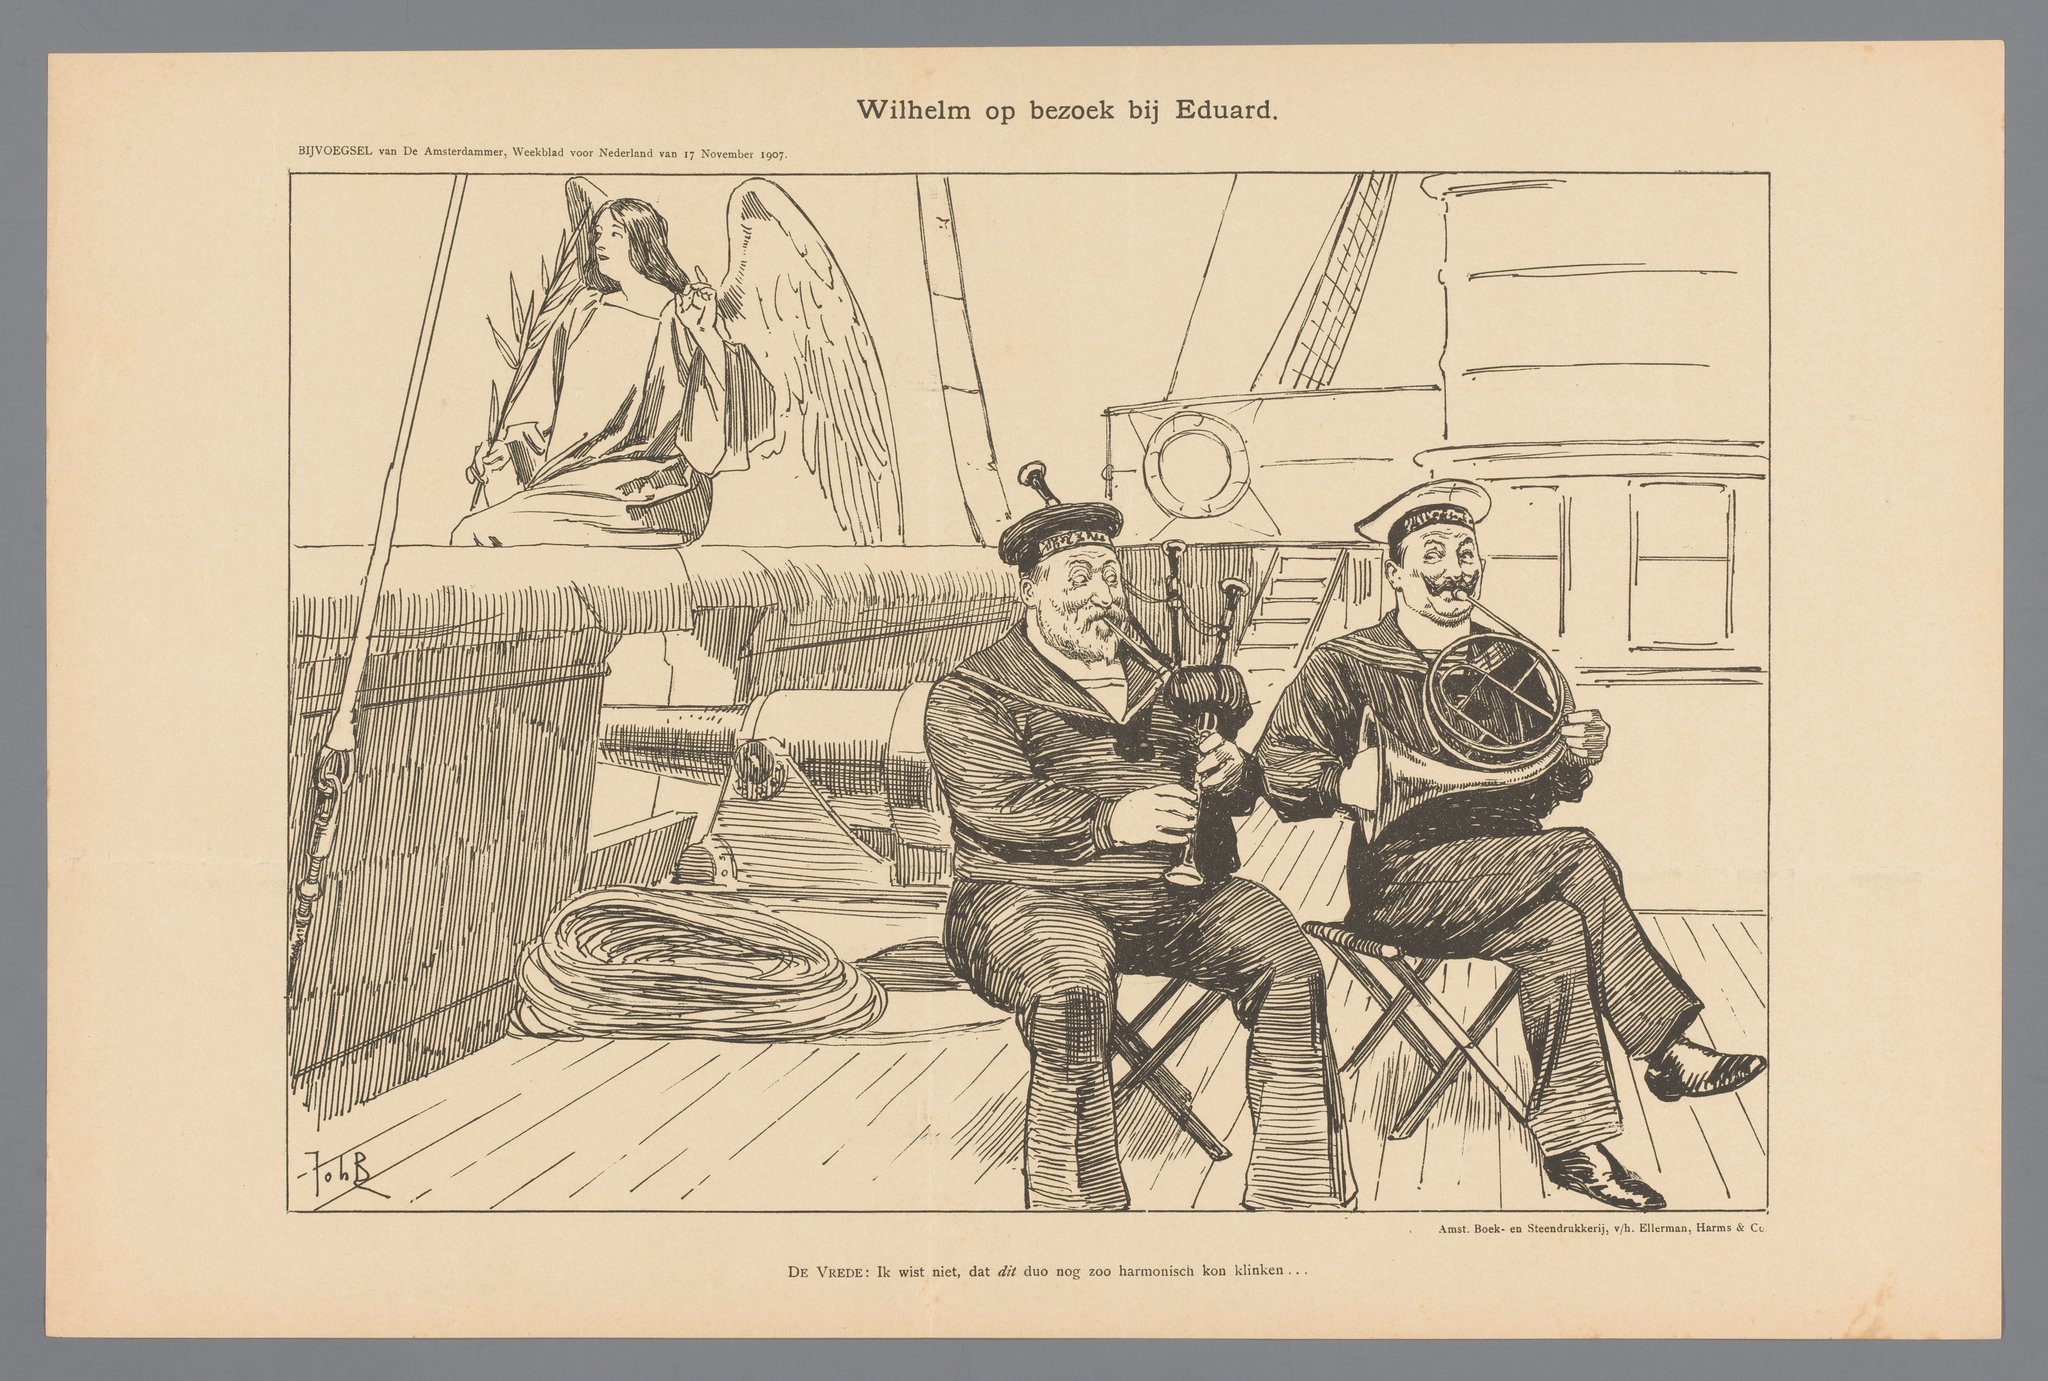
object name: cartoon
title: Wilhelm op bezoek bij Eduard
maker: johan braakensiek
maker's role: draughtsman, print maker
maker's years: 1858-1940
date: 1907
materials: paper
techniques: lithograph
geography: amsterdam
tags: wilhelm ii (keizer van duitsland), symbols, allegories of peace, 'pax'; 'pace' (ripa), bagpipe, musette, historical persons, ruler, sovereign, peace, political caricatures and satires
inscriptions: date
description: Prent uit het bijvoegsel van: De Amsterdammer. Weekblad voor Nederland, 17 november 1907.